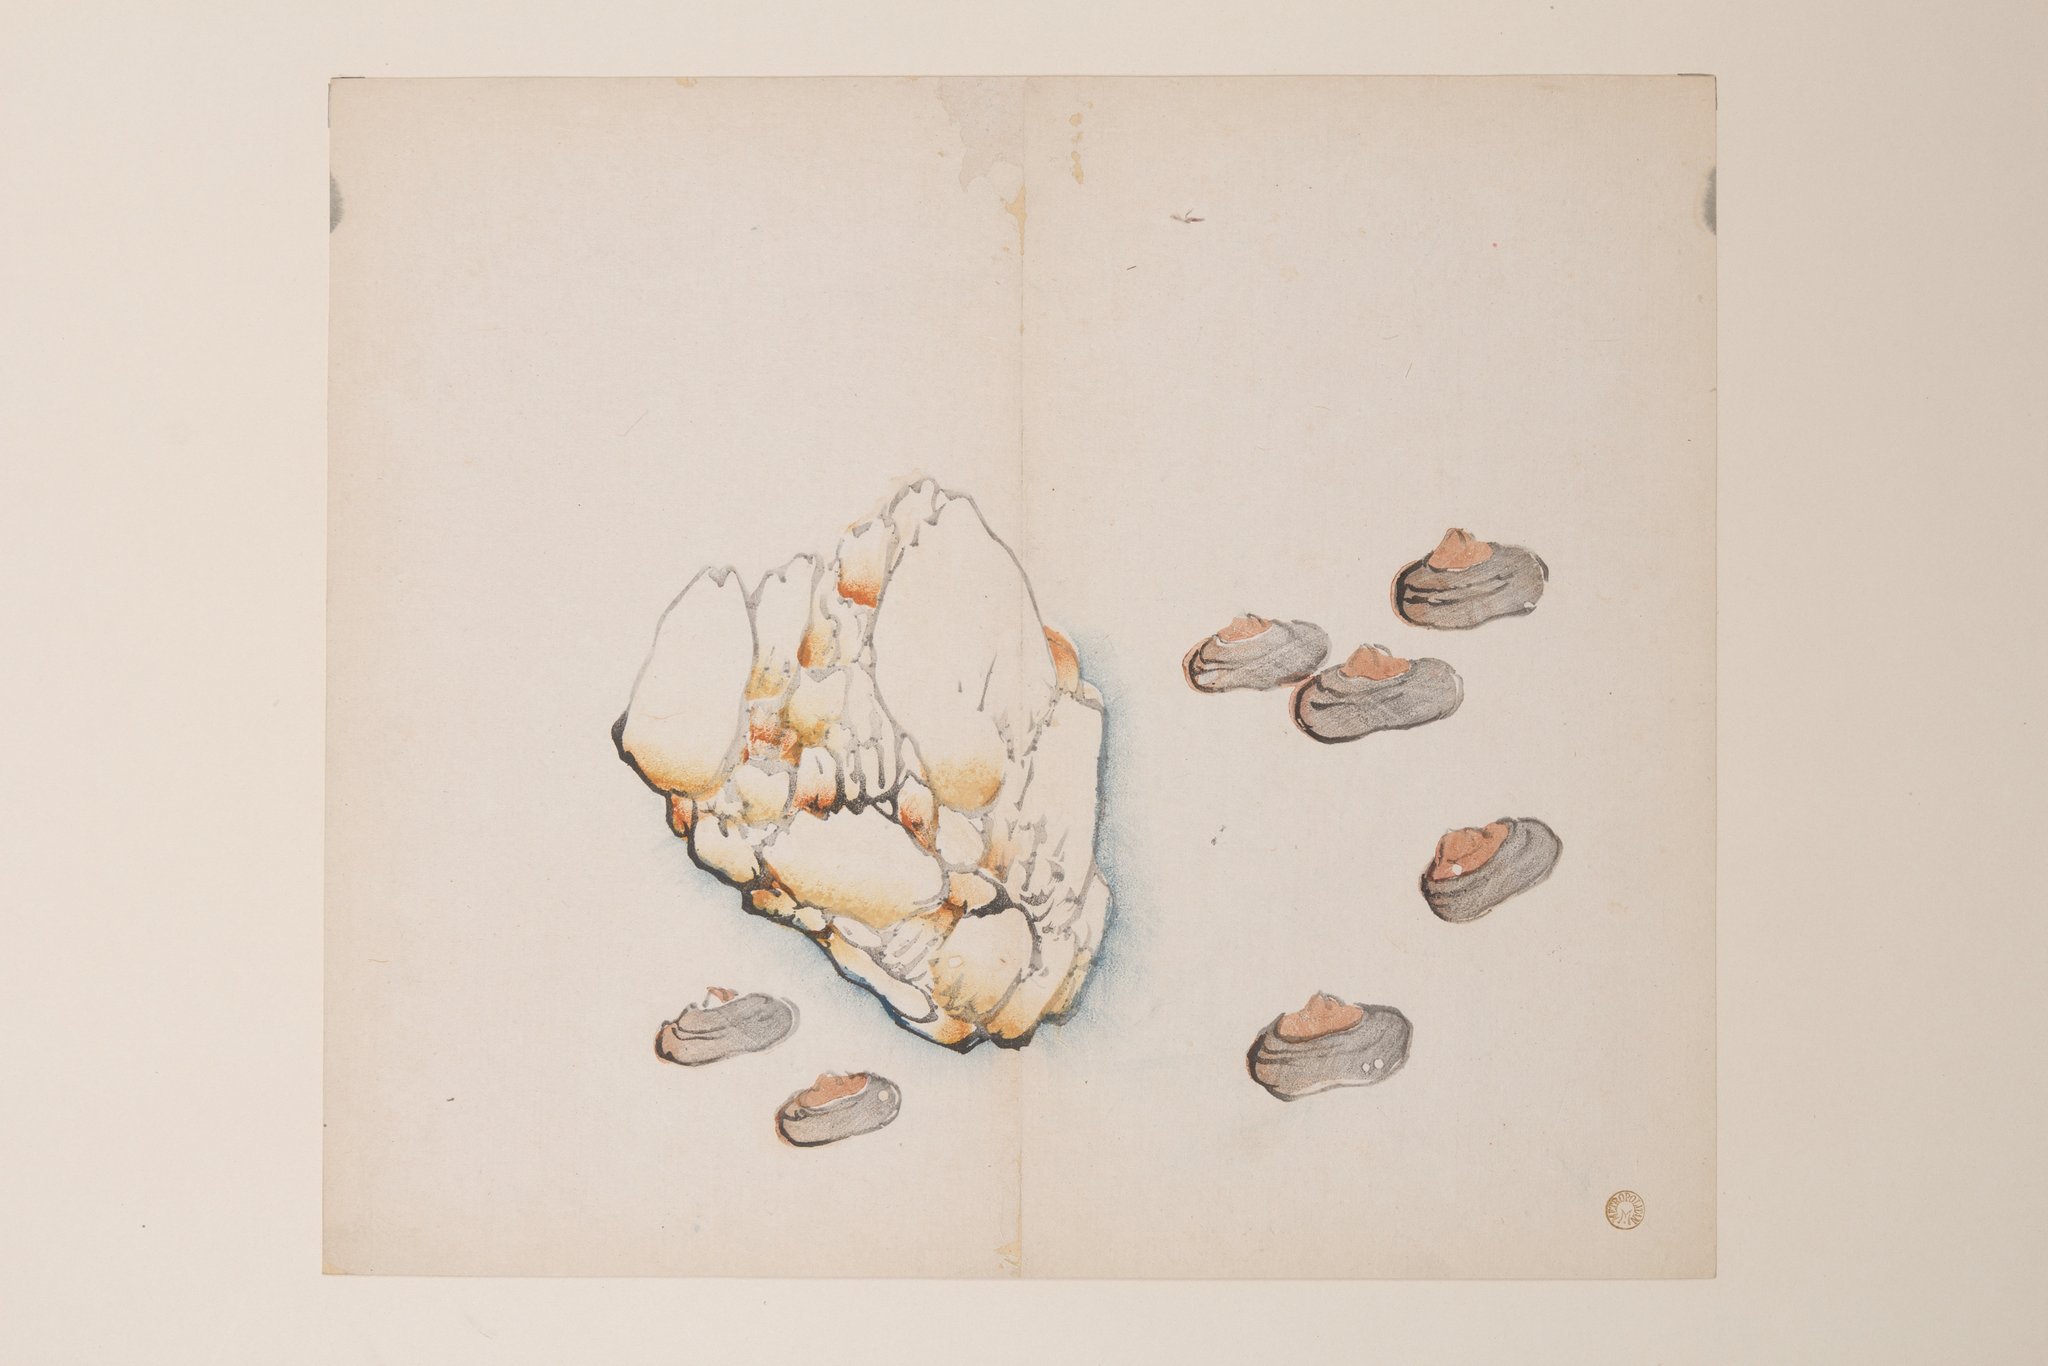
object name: print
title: Page from the Ten Bamboo Studio Manual of Painting and Calligraphy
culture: chinese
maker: hu zhengyan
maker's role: artist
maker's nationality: chinese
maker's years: 1584-1634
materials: ink, paper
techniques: printing